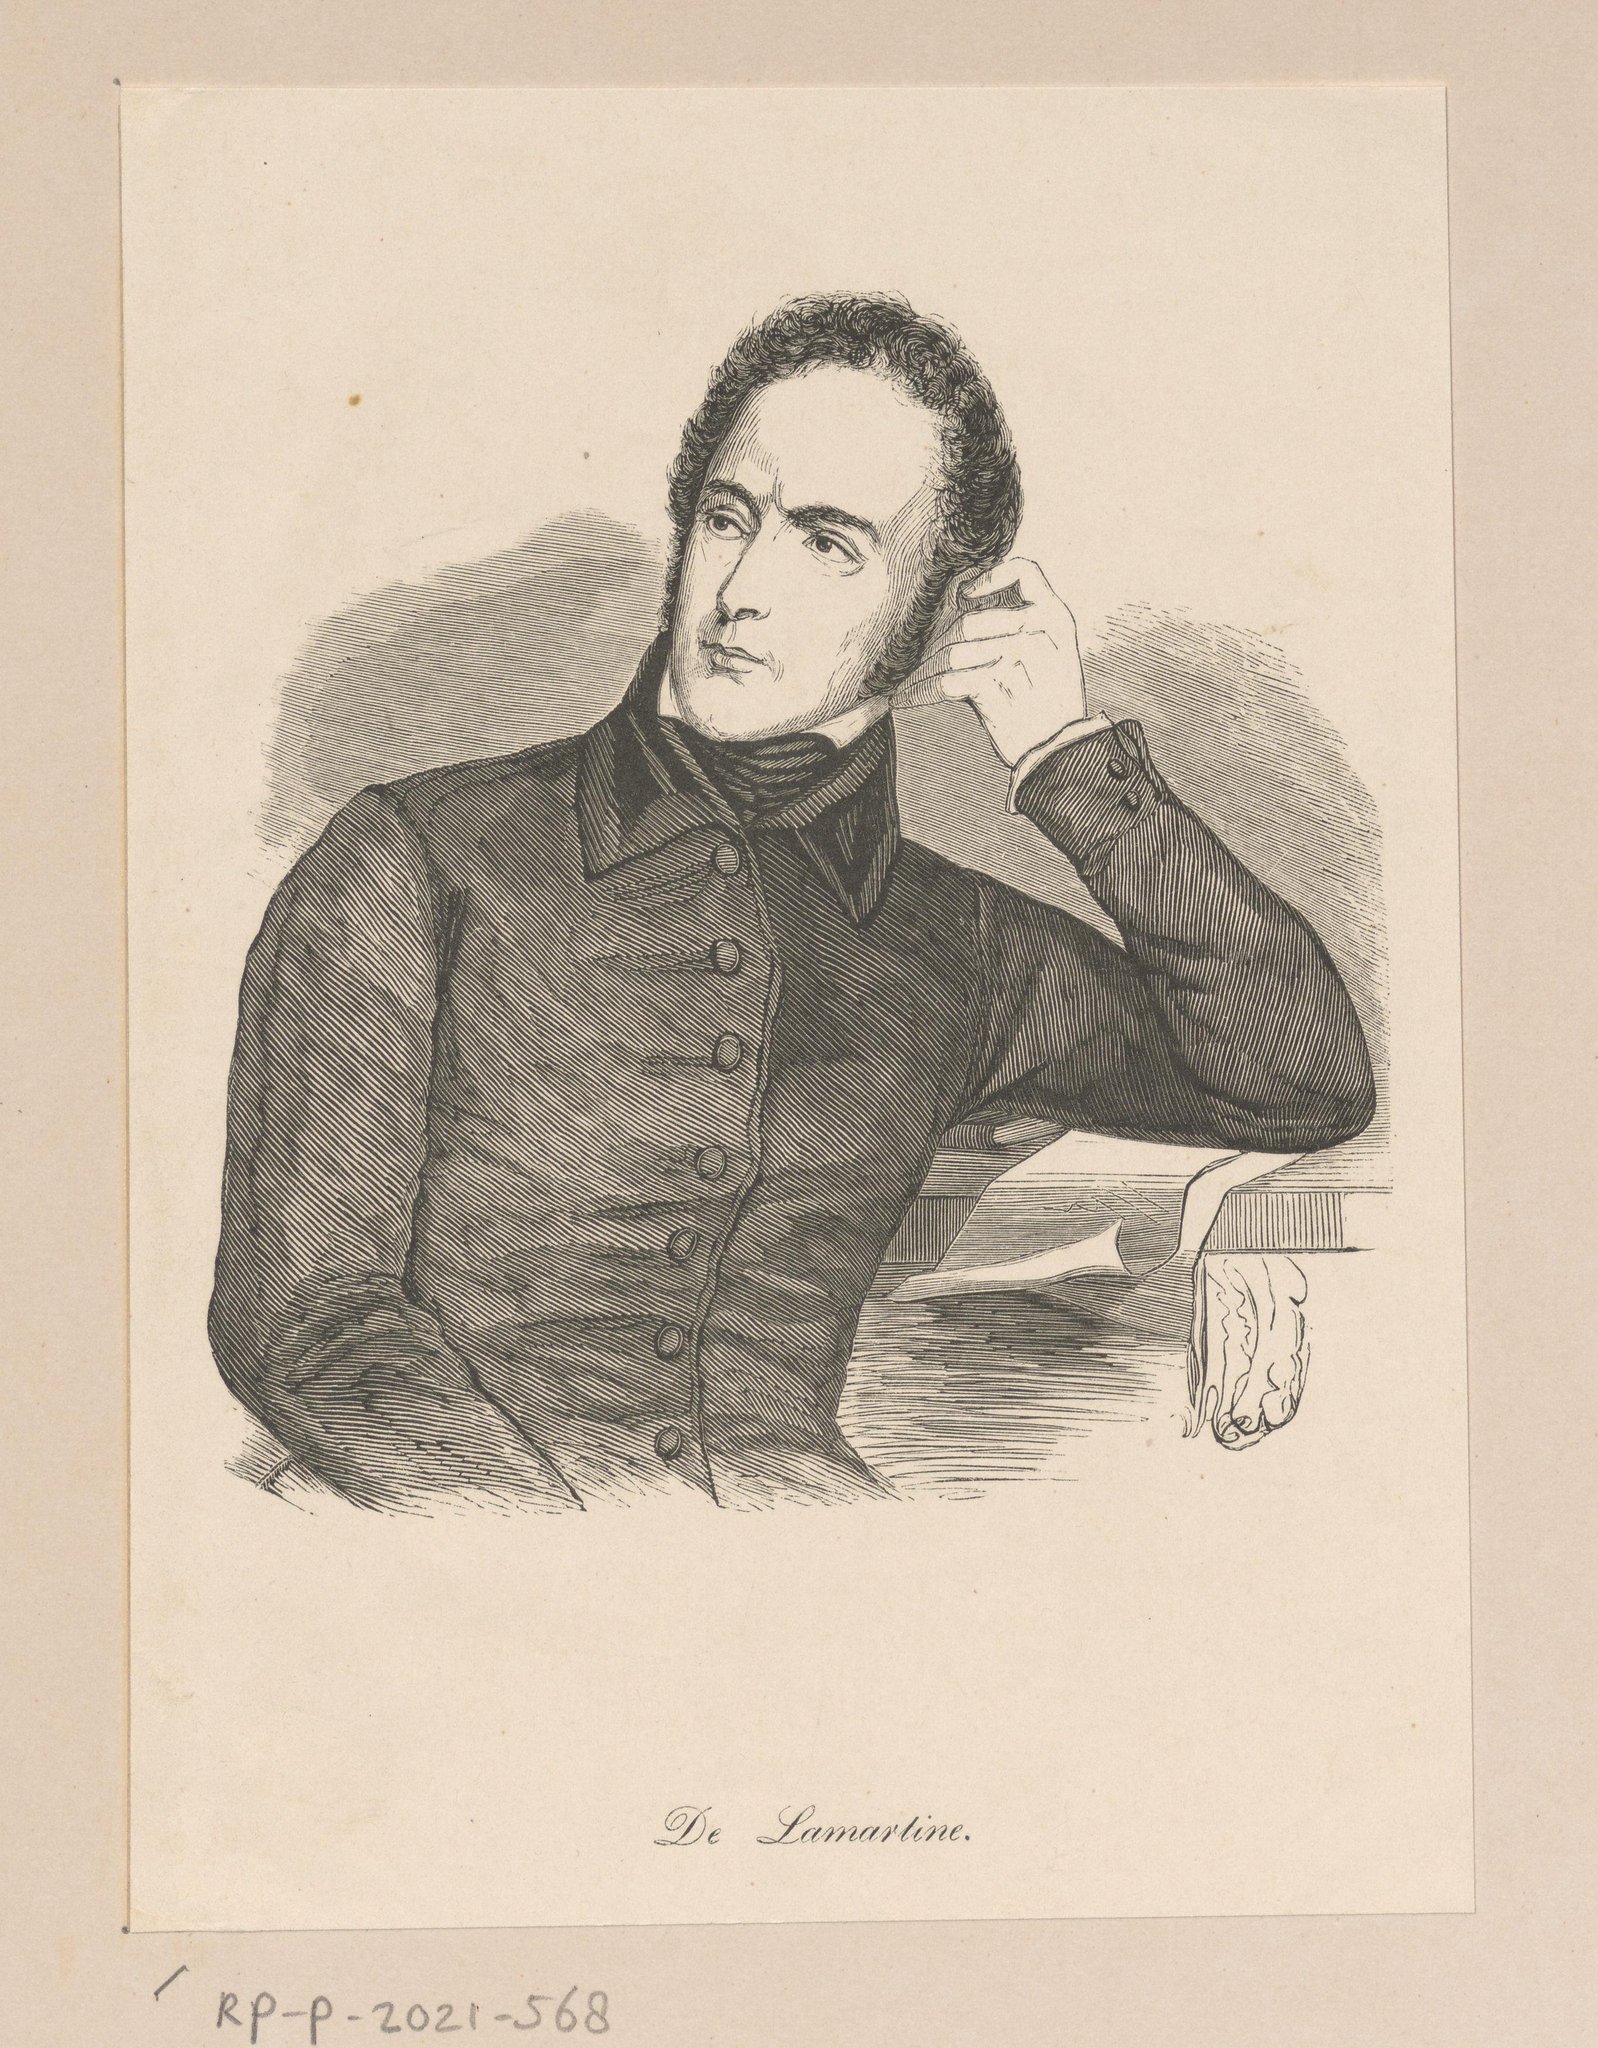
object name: print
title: Portret van Alphonse de Lamartine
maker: Anonymous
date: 1820-1899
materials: paper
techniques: engraving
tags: paris, historical persons, portrait of a writer